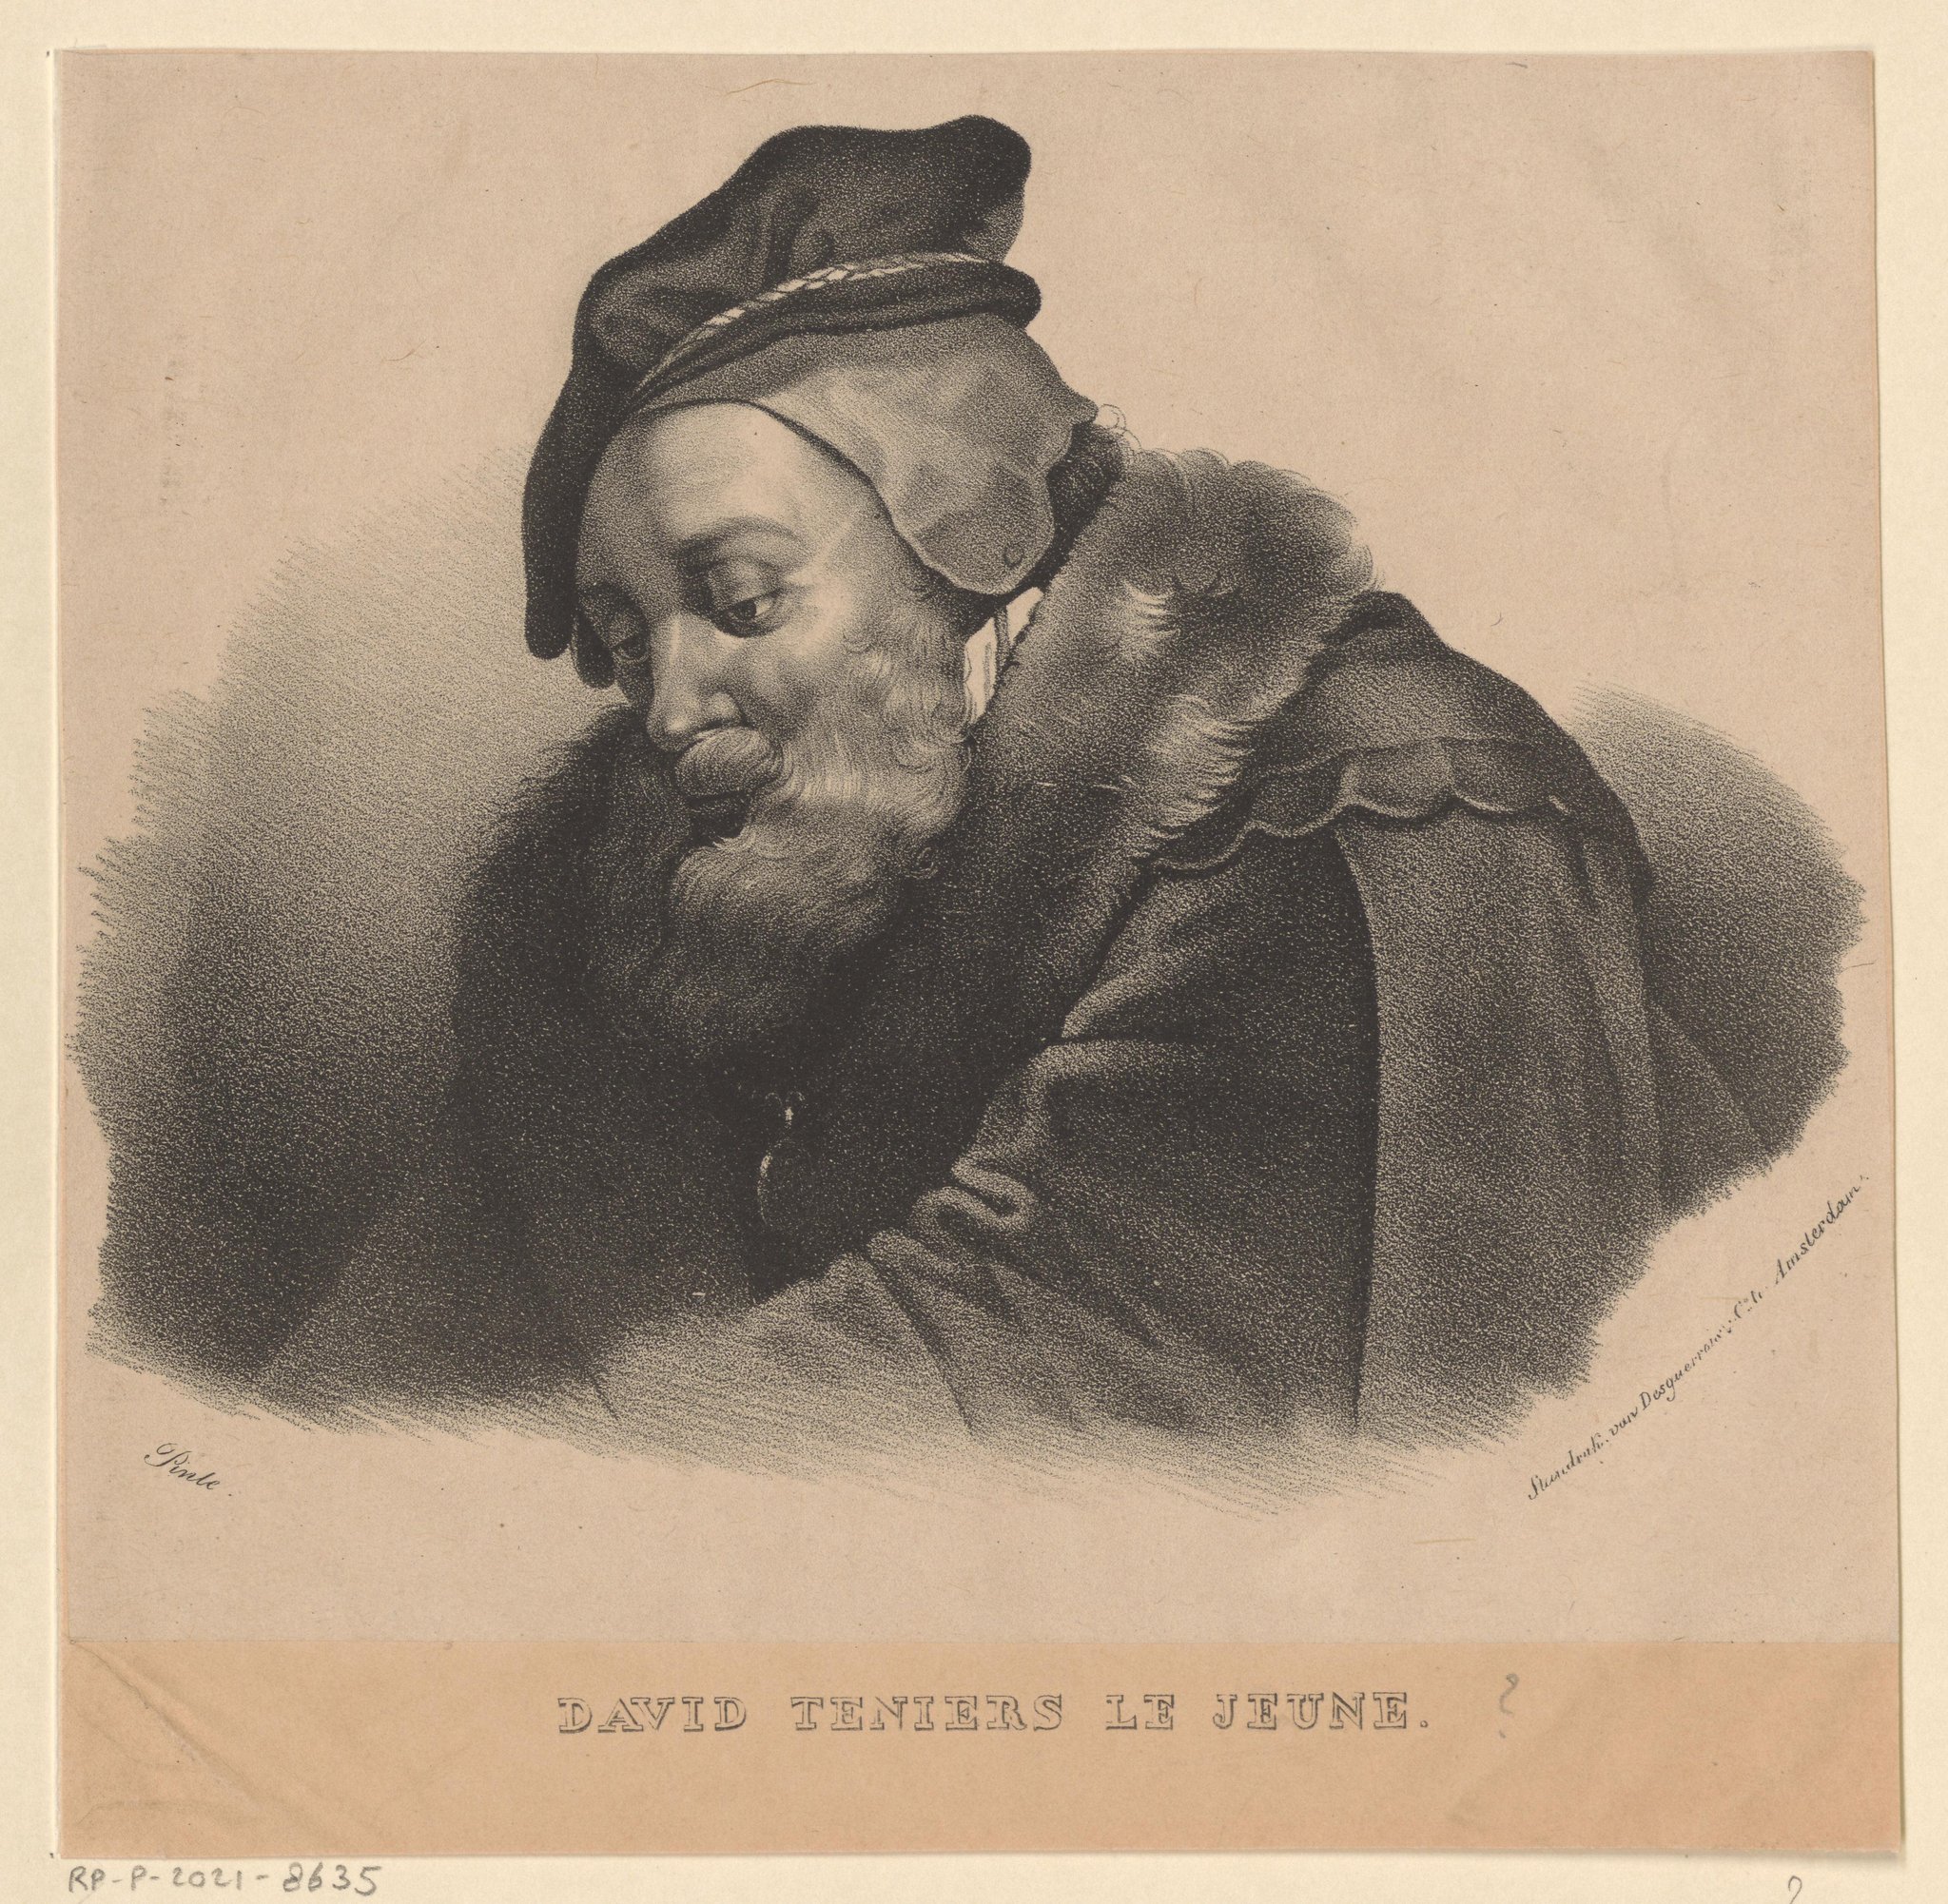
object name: print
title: Portret van David Teniers II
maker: m. pinte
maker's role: print maker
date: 1827-1850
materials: paper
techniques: lithograph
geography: amsterdam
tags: brussels, painter, print maker, draughtsman, david teniers (ii), historical persons, portrait, self-portrait of painter